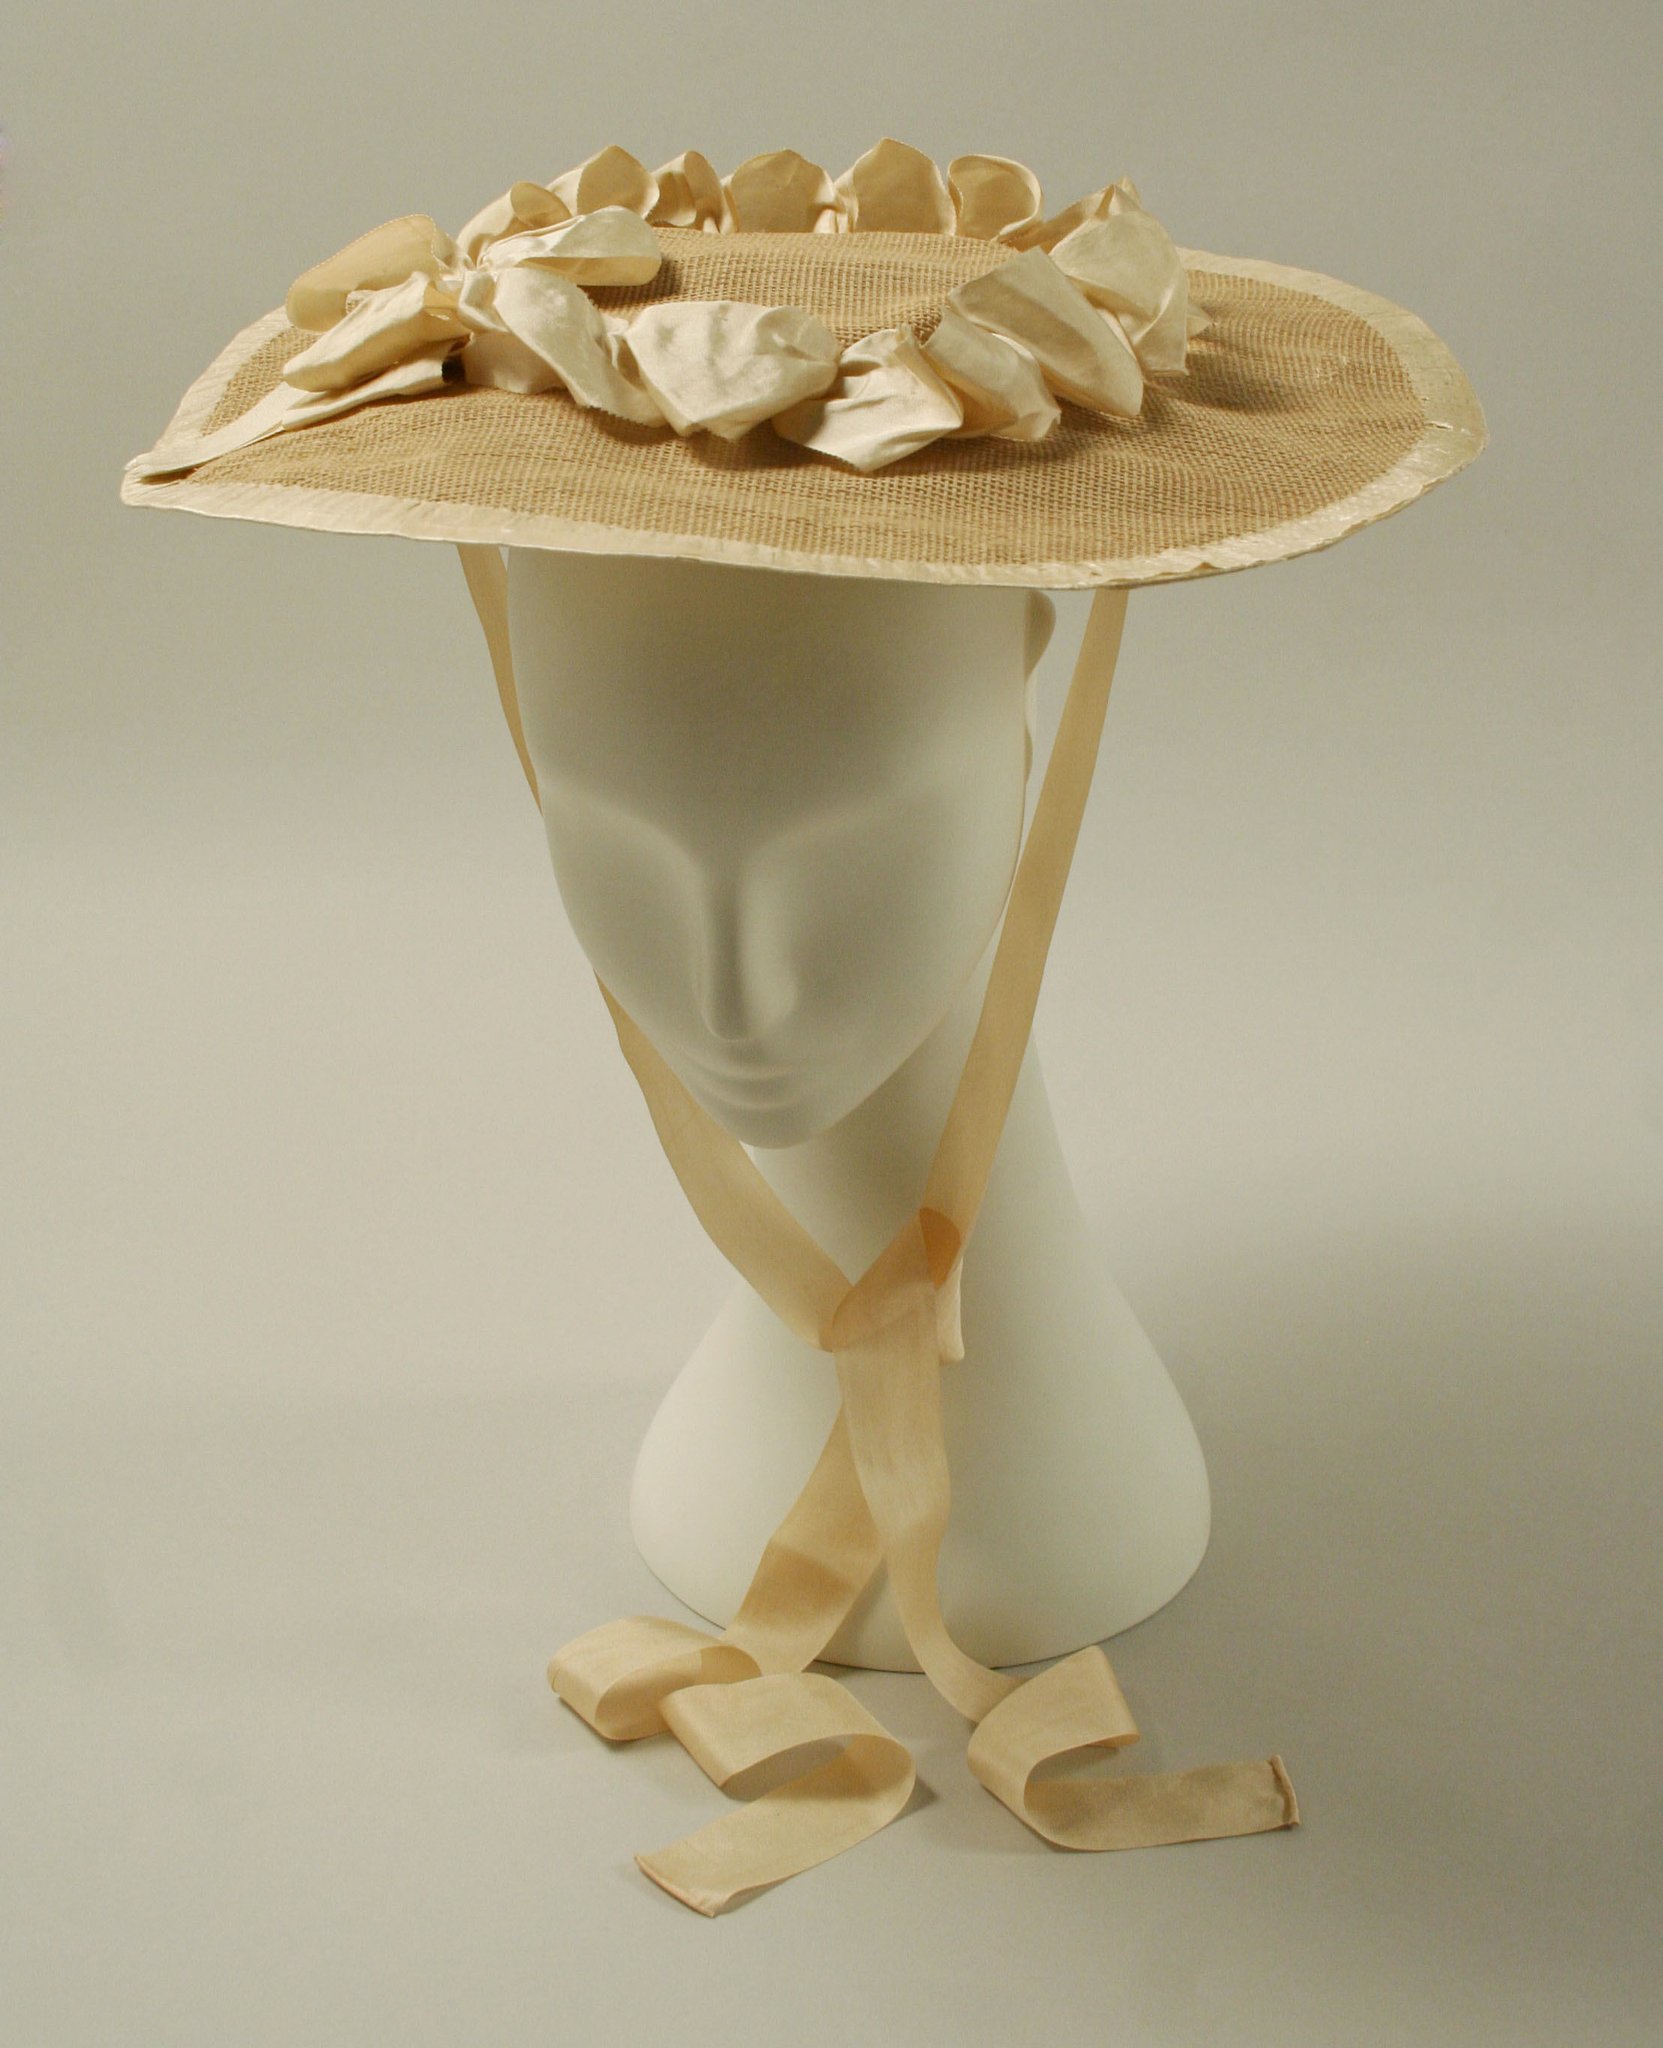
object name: hat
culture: british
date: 1760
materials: raffia, silk